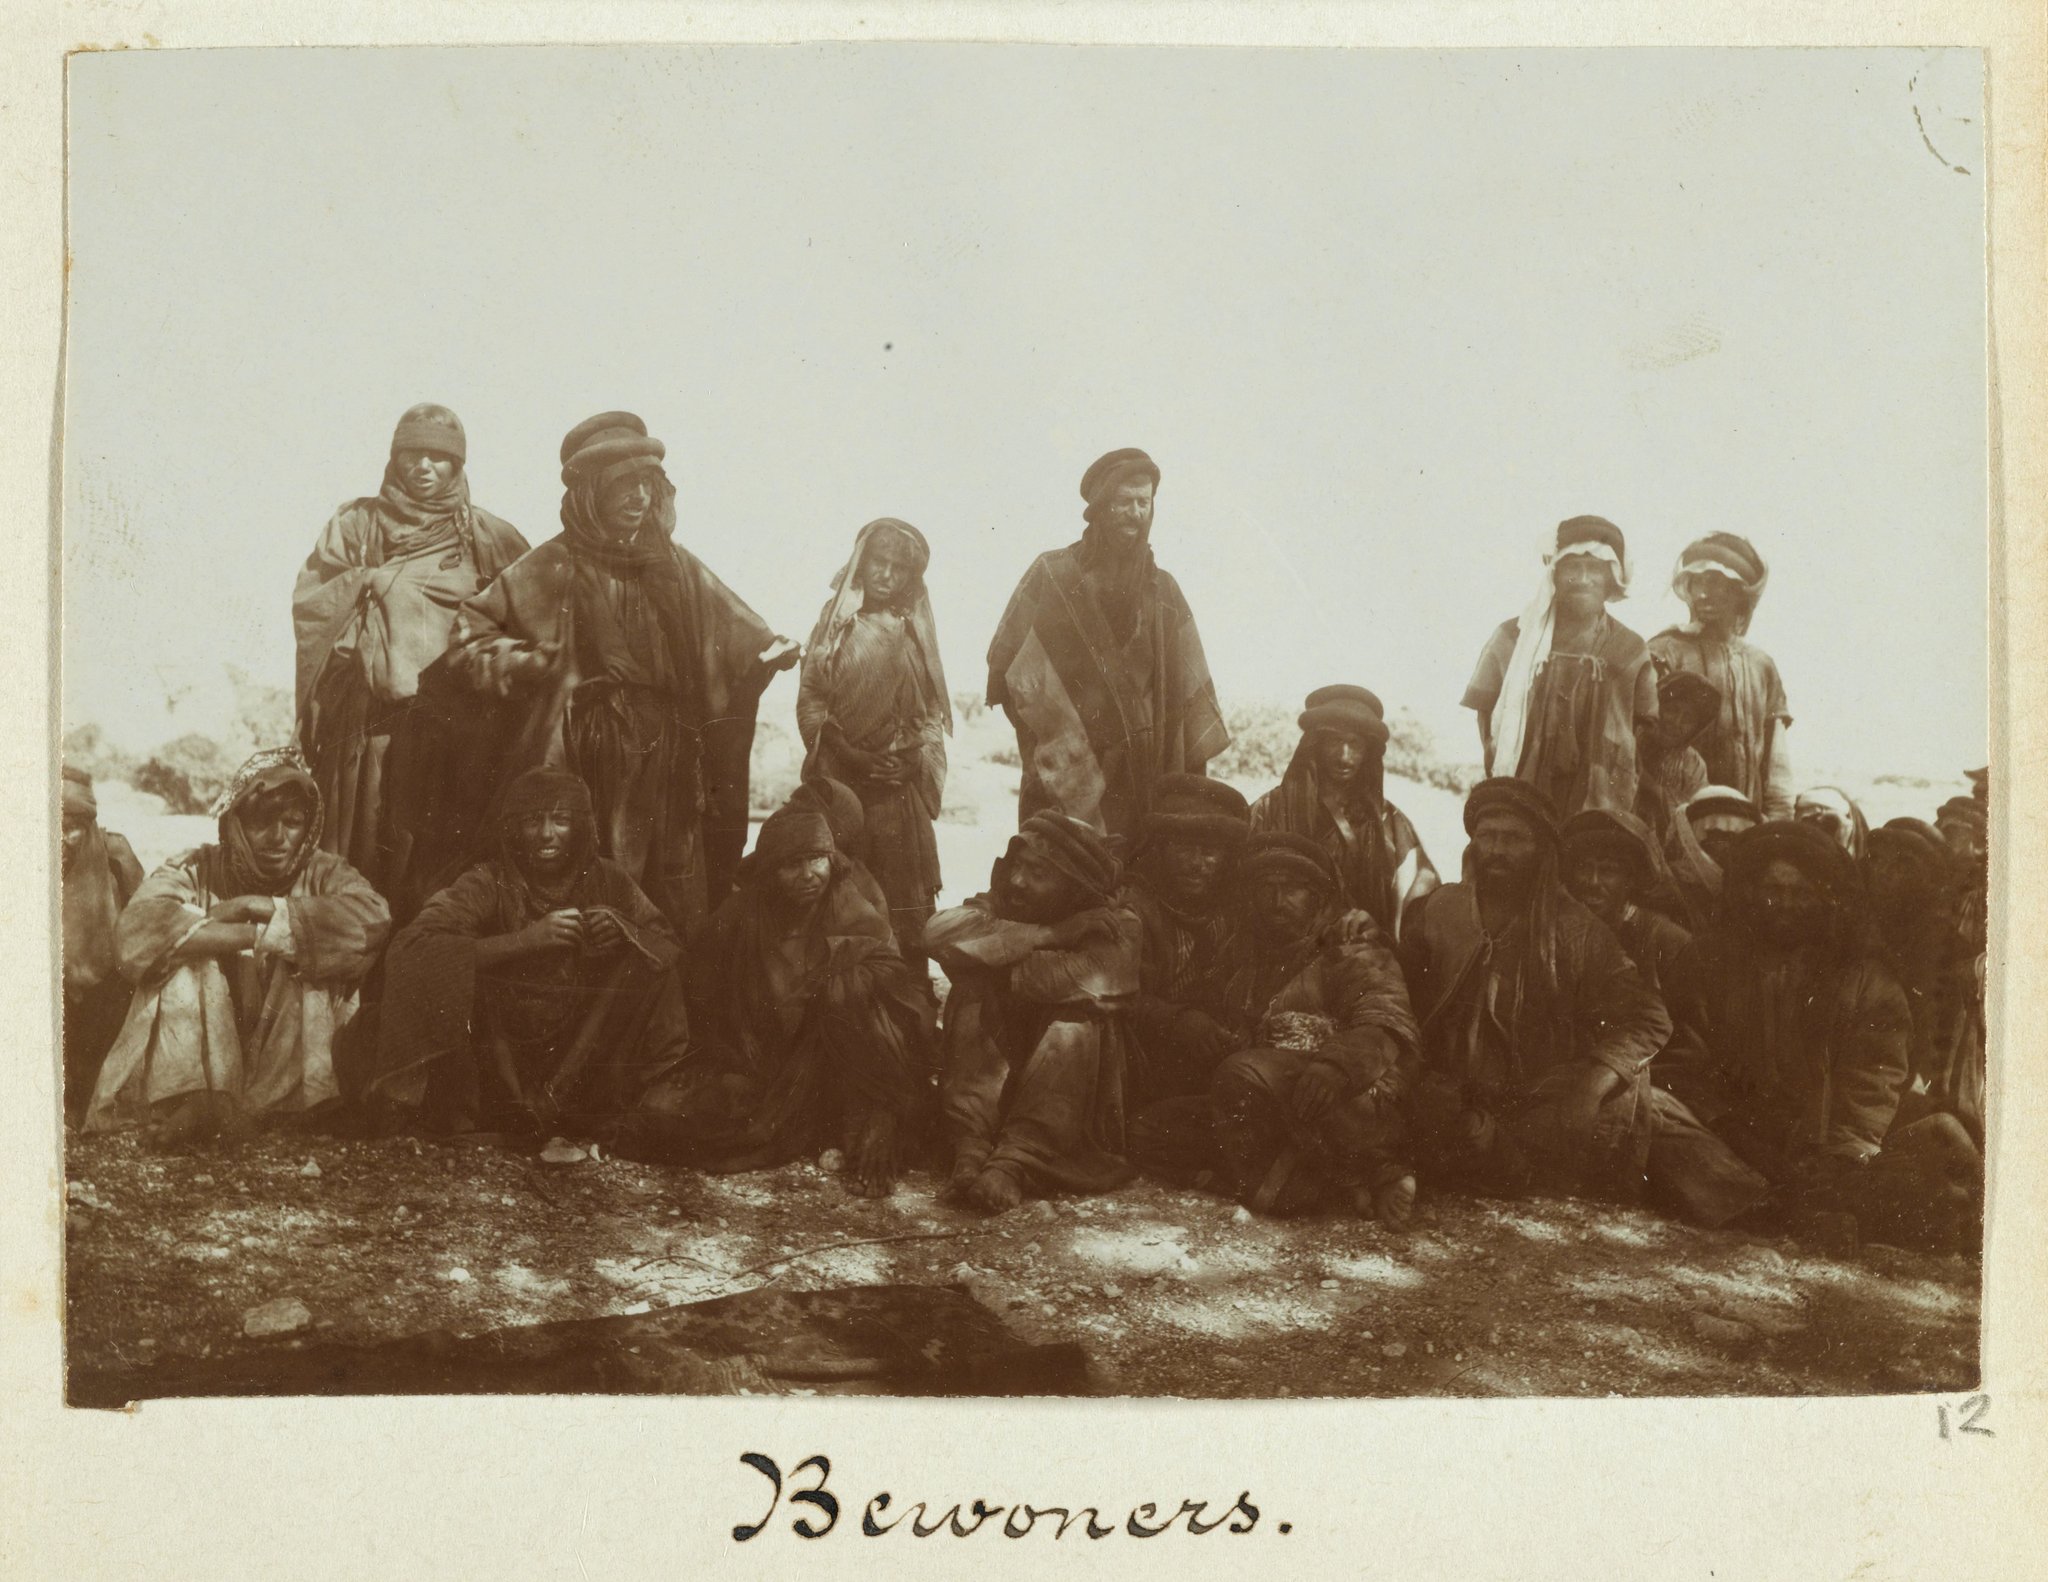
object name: page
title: Bewoners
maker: johannes lodewijk heldring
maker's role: fotograaf, predikant, schrijver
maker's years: 1852-1923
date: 1898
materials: paper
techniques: collodion silver print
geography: jordan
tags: anonymous historical persons portrayed in a group, in a group-portrait